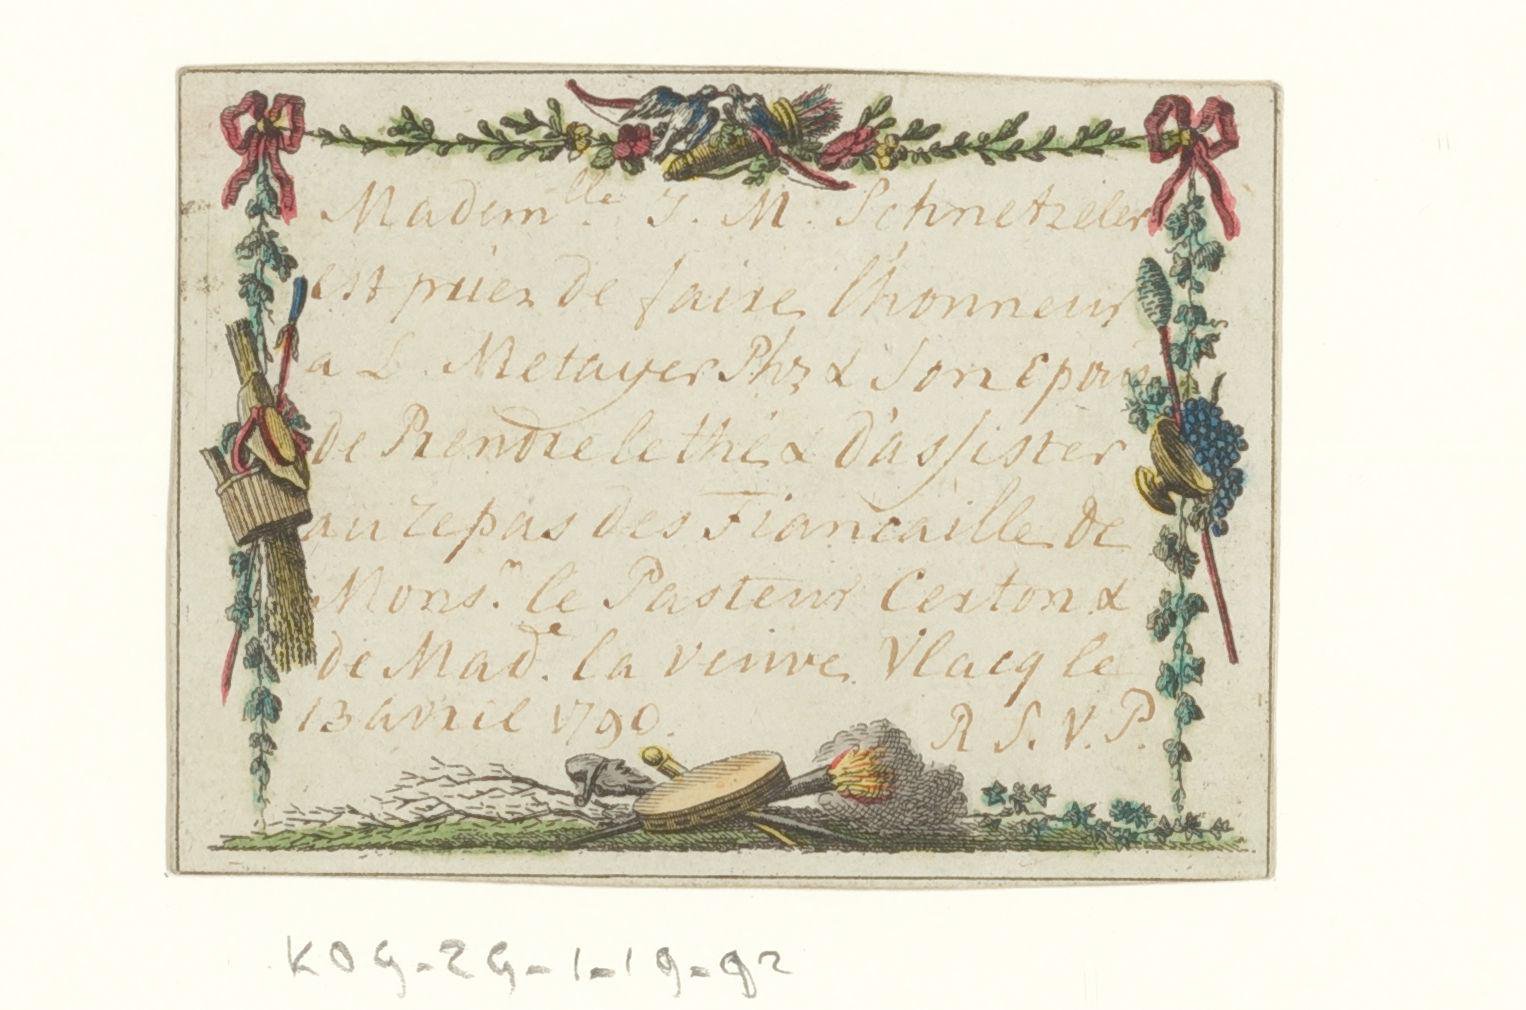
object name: print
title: Uitnodiging aan Madem.elle J.M. Schnetzler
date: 1704-1790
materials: paper, watercolor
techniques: etching, hand coloring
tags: louis metayer phzn., rotterdam, catharina elisabeth metayer, johanna magdalena schnetzler, antoinette bernard, letter, envelope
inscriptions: collector's mark, collector's mark: Lugt 1641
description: Kaartje met een handgeschreven uitnodiging en RSVP aan mej. J.M. Schnetzler, namens L. Metayer en zijn vrouw voor het verlovingsdiner van de predikant Henri Abraham Certon en Mad.e la Veuve Vlacq (Catharina Elisabeth Metayer) op 13 april 1790. Onderdeel van een groep van bruilofts- en invitatiekaartjes van de families Bernard en Metayer. Onderwerpsrubrieken binnen de Atlas Zeden en Gewoonten: Des Menschen Begin, Midden en Einde. Bruiloft en huwelijk.